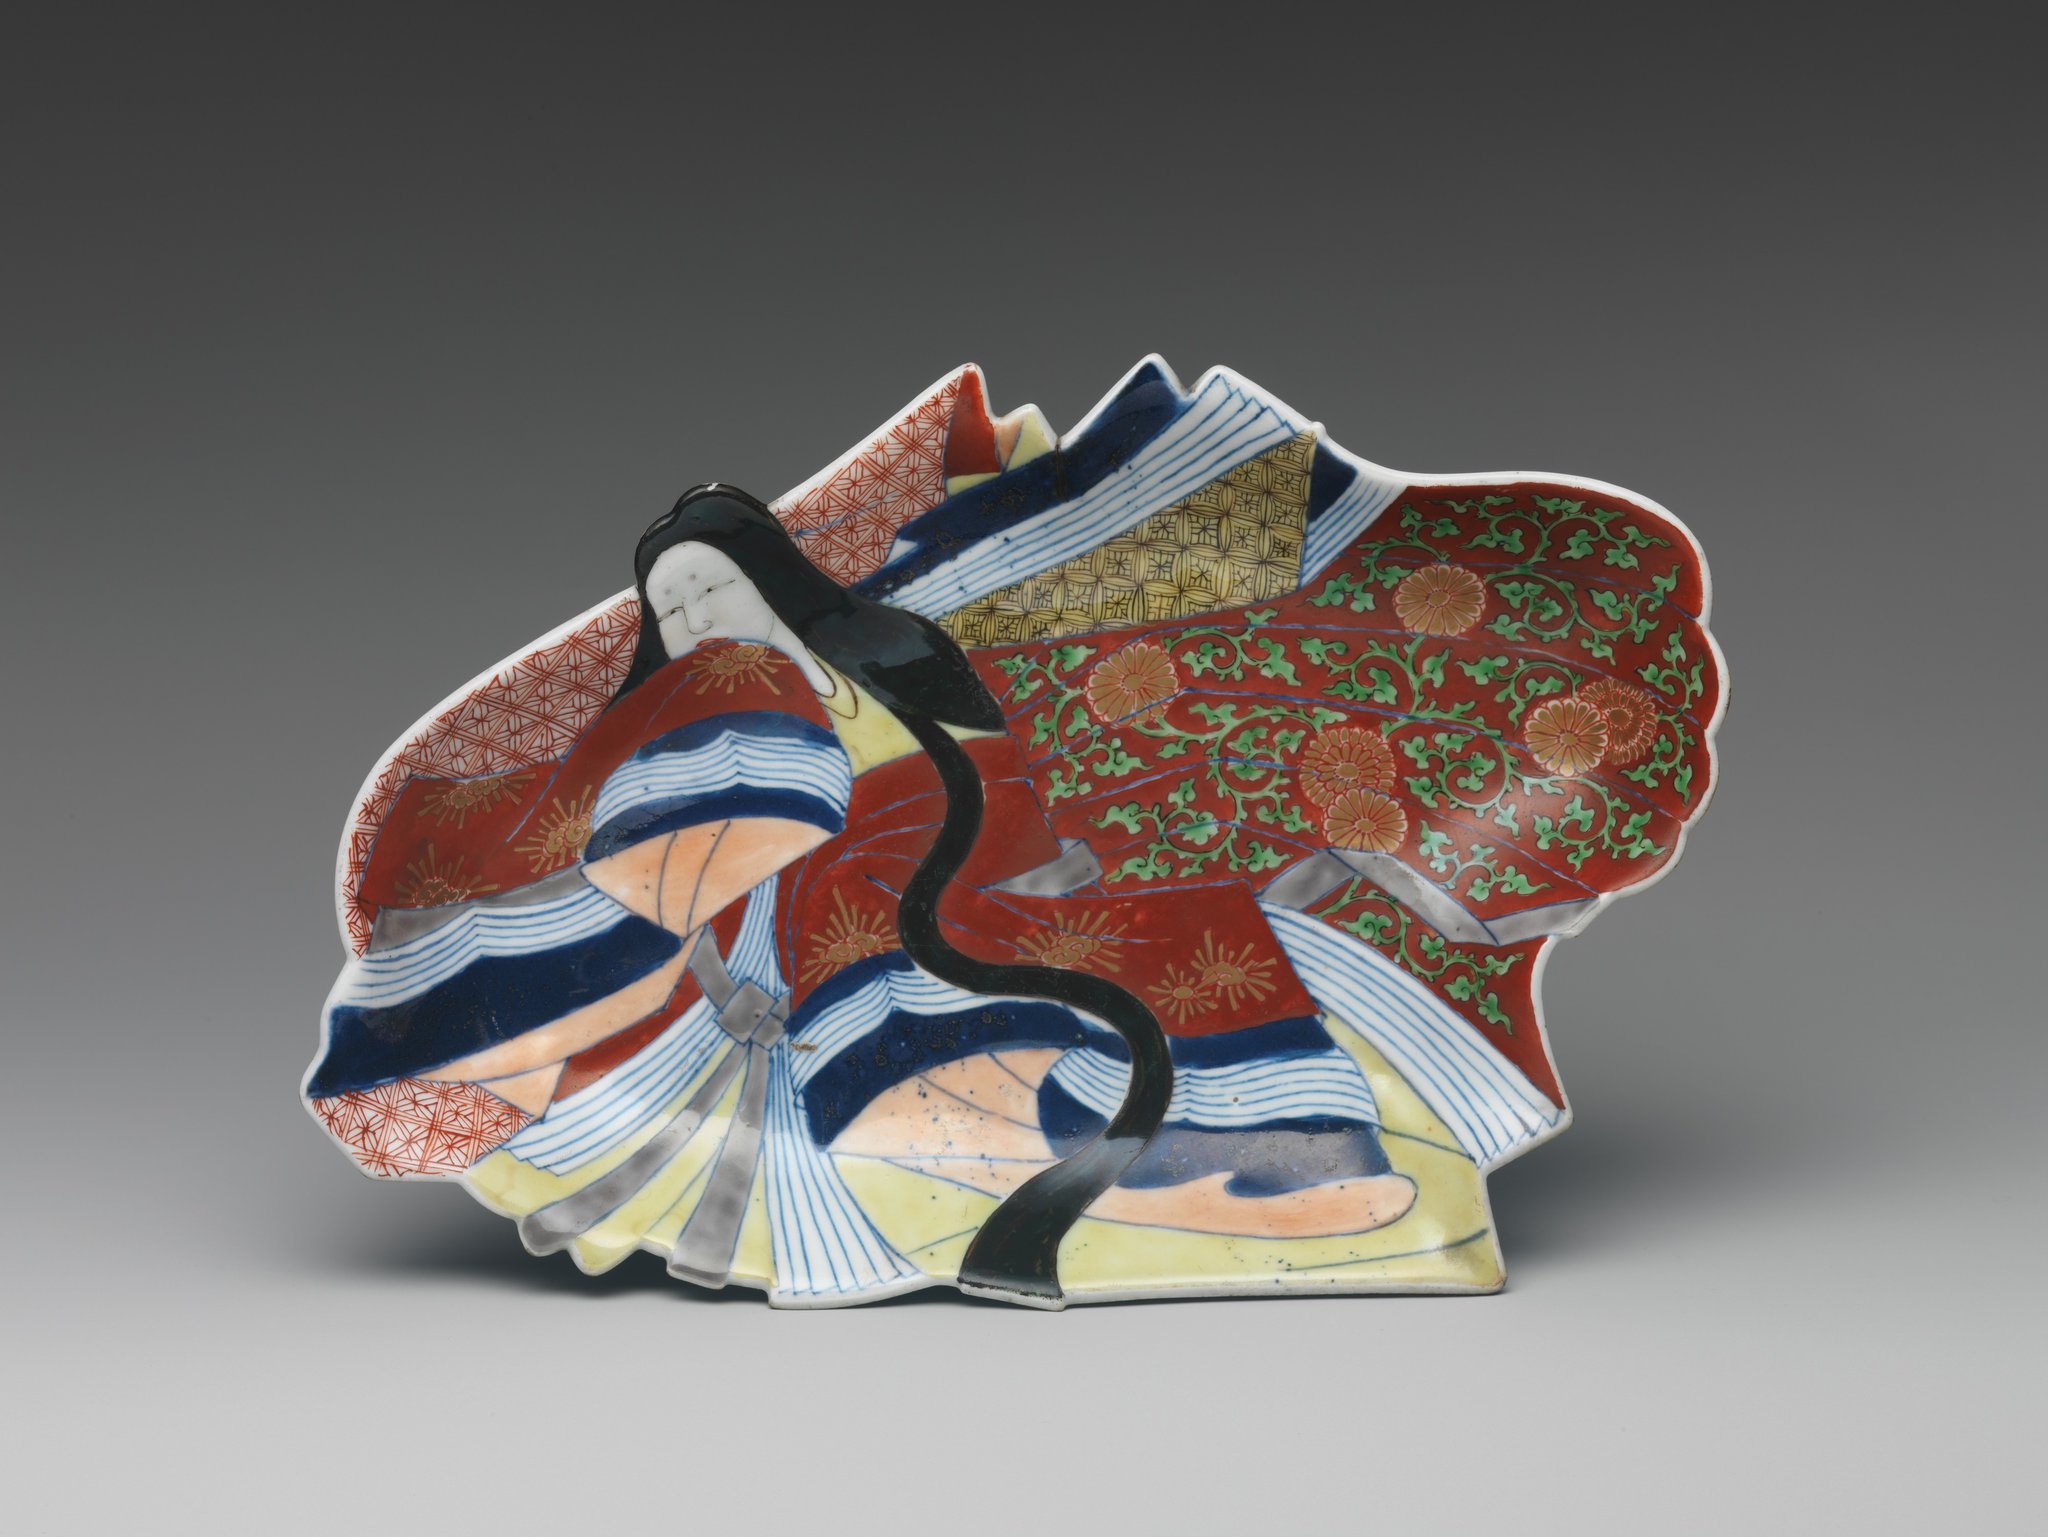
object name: plate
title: Dish in the Shape of a Princess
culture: japanese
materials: enamel, porcelain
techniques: overglaze, underglaze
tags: women